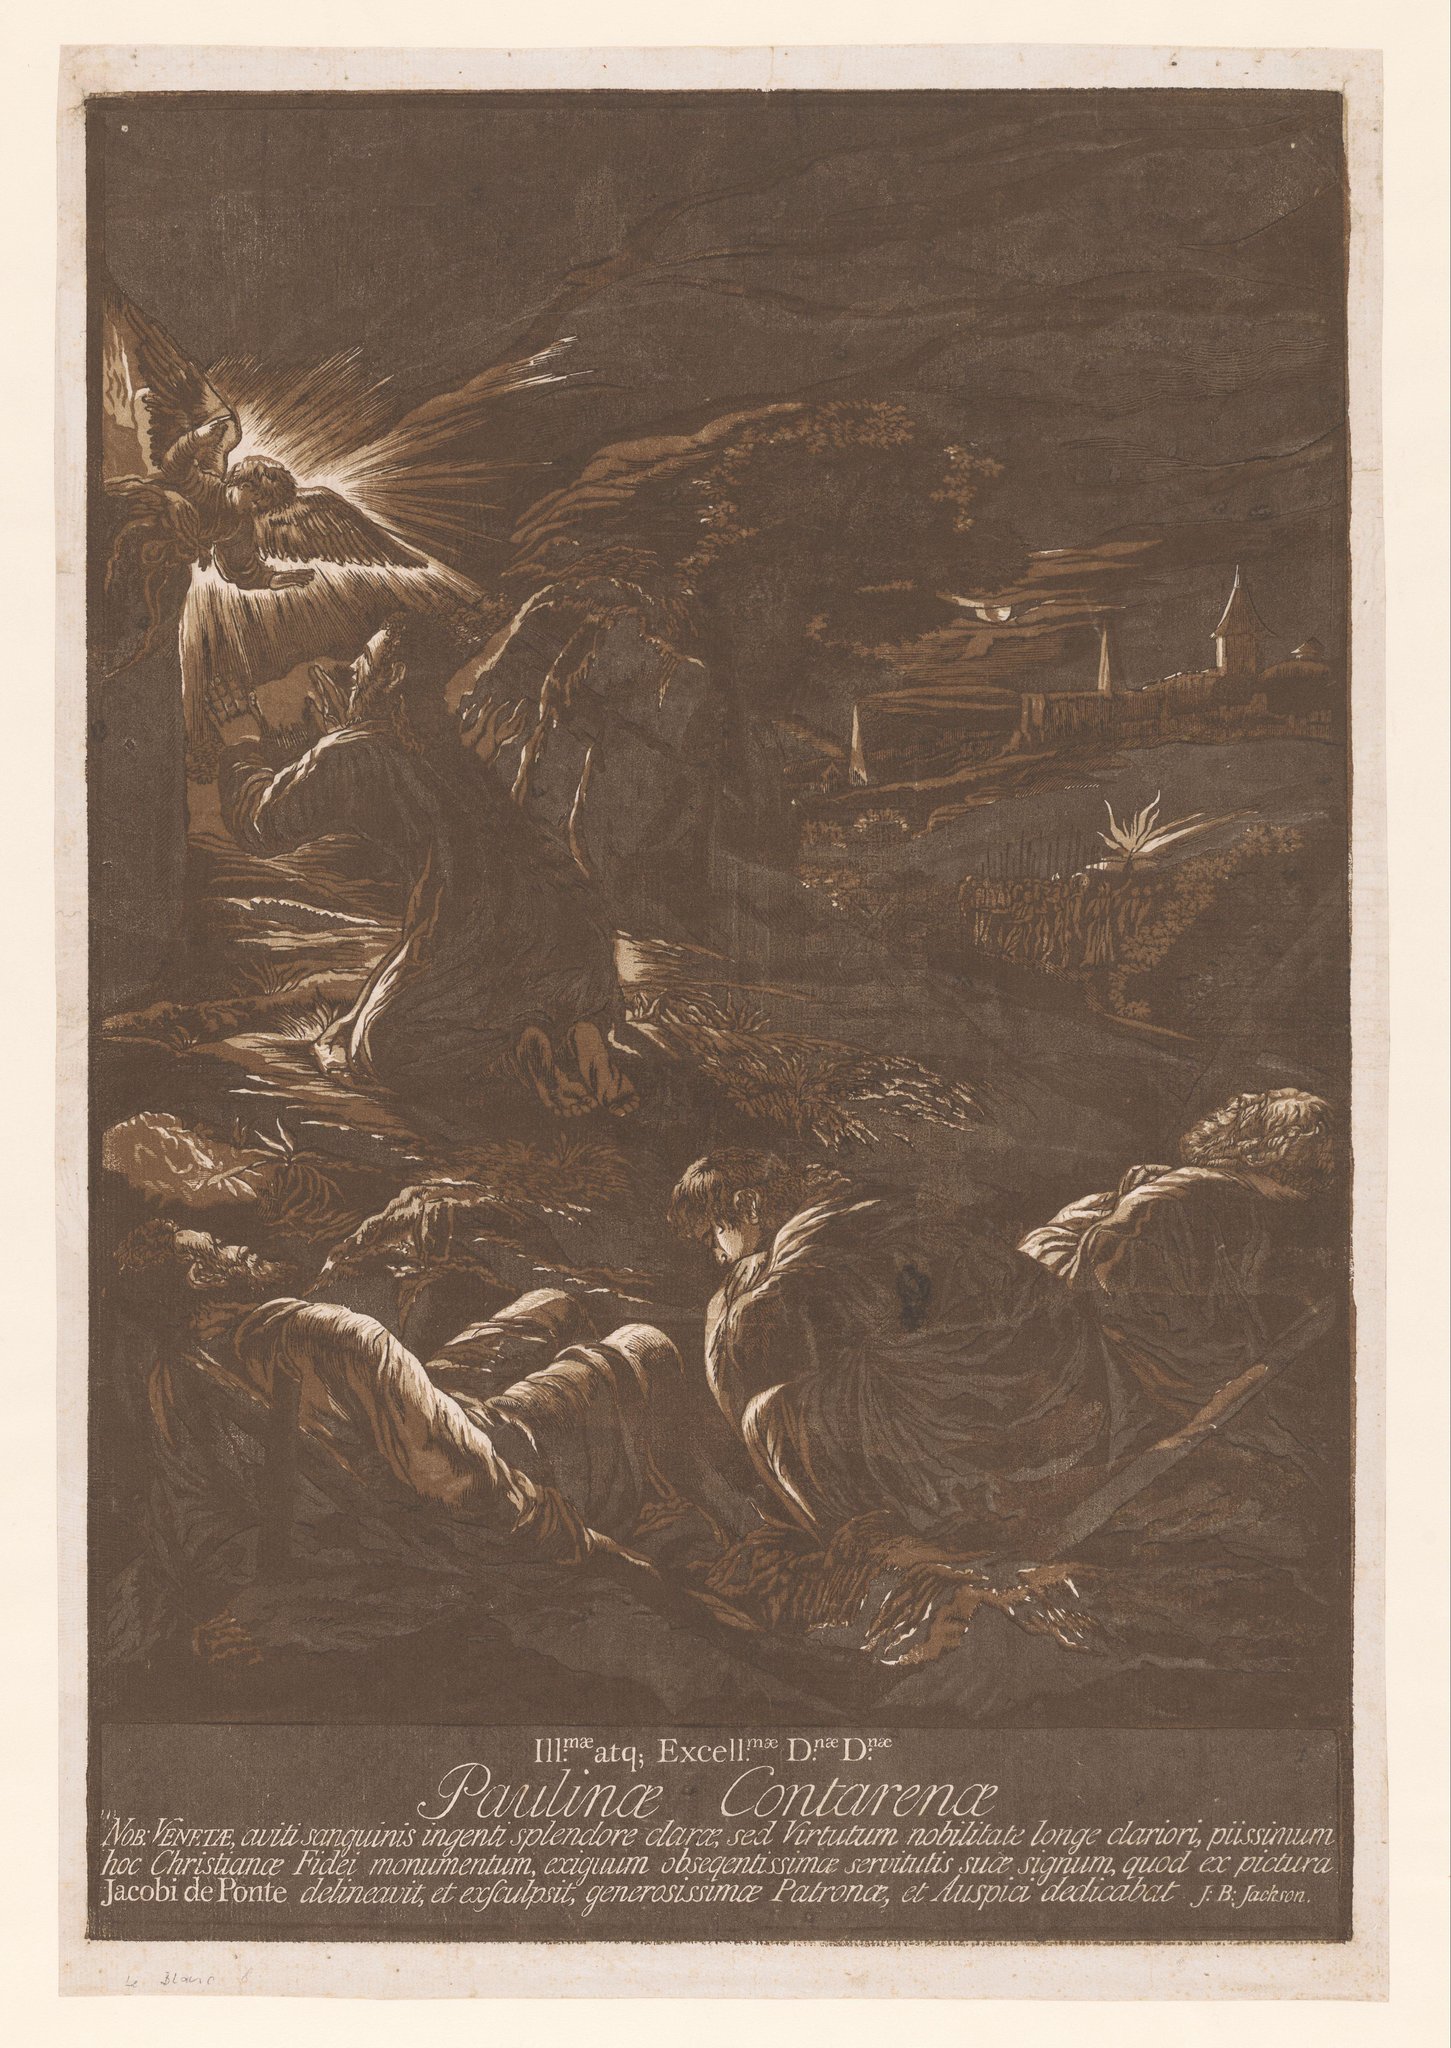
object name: print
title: Christus in de hof van Getsemane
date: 1745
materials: paper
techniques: woodcut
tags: christ's prayer in the garden of gethsemane during the night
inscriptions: collector's mark: Lugt 2228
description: Op het recto een proefdruk van één blok in bruin, voorstellende de presentatie van Maria in de tempel. Zie British Museum nr. 1958,0712.84. Prent maakt deel uit van een ongenummerde serie van 24 prenten.